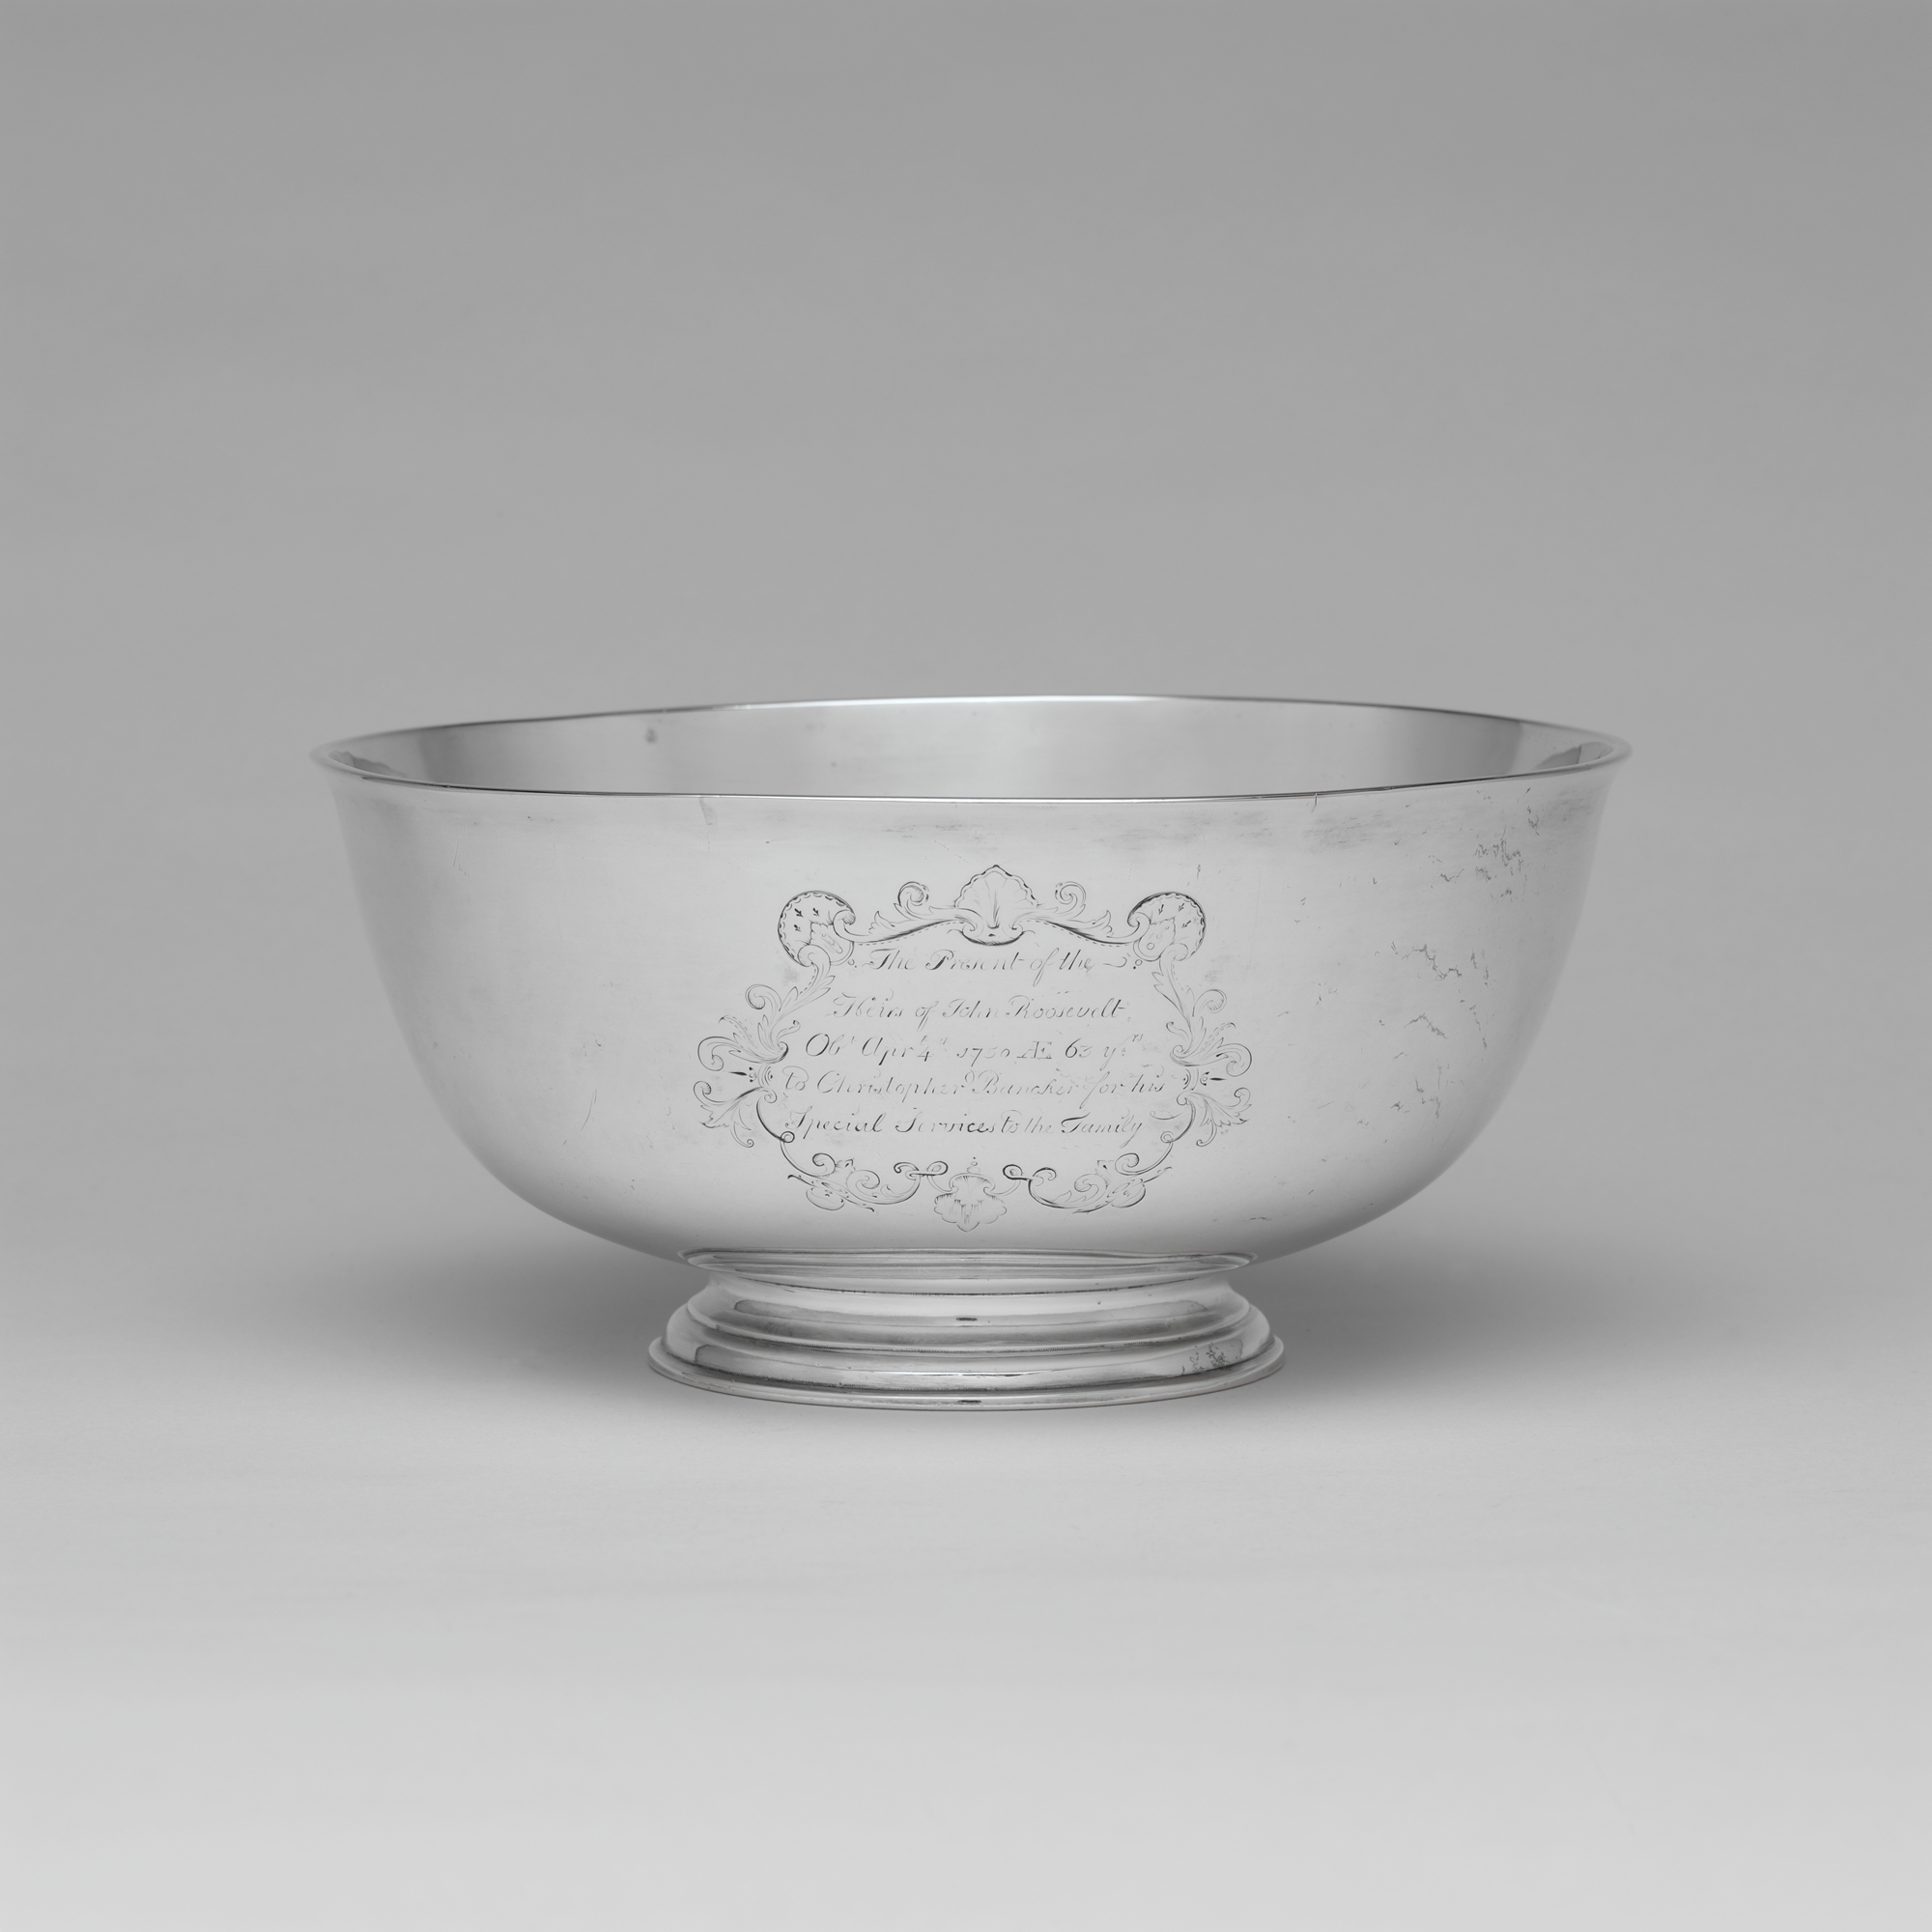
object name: bowl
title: Punch Bowl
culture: american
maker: adrian bancker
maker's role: maker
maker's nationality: american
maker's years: 1703-1772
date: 1750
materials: silver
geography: united states